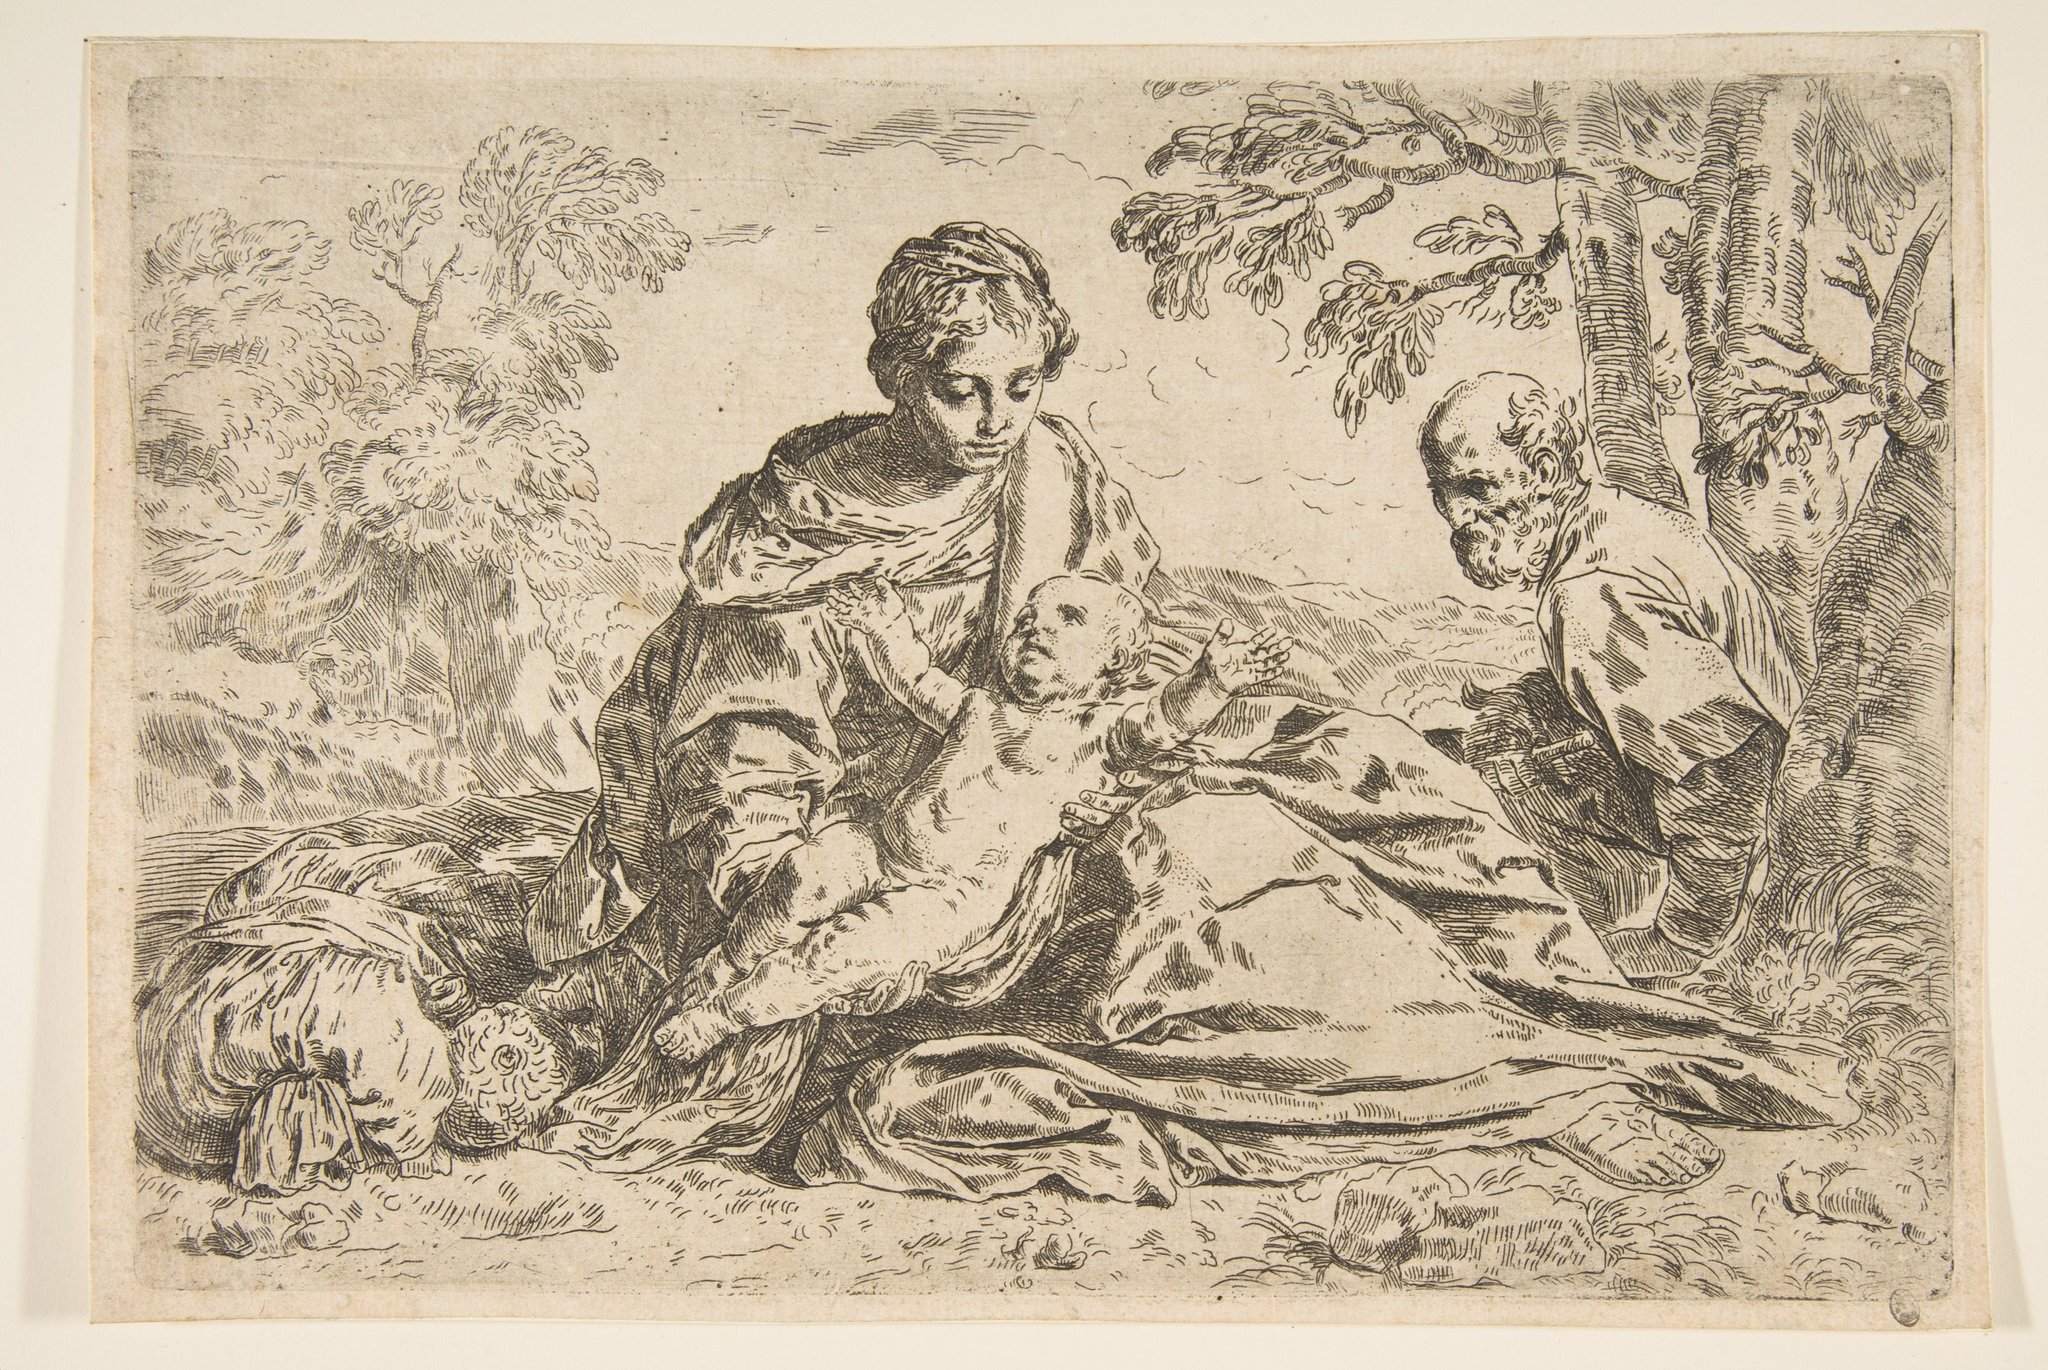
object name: print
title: Rest on the flight into Egypt, Mary holding the infant Christ with St. Joseph at right, copy after Cantarini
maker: simone cantarini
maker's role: artist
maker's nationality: italian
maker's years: 1612-1648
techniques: etching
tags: infants,christ,virgin mary,saints